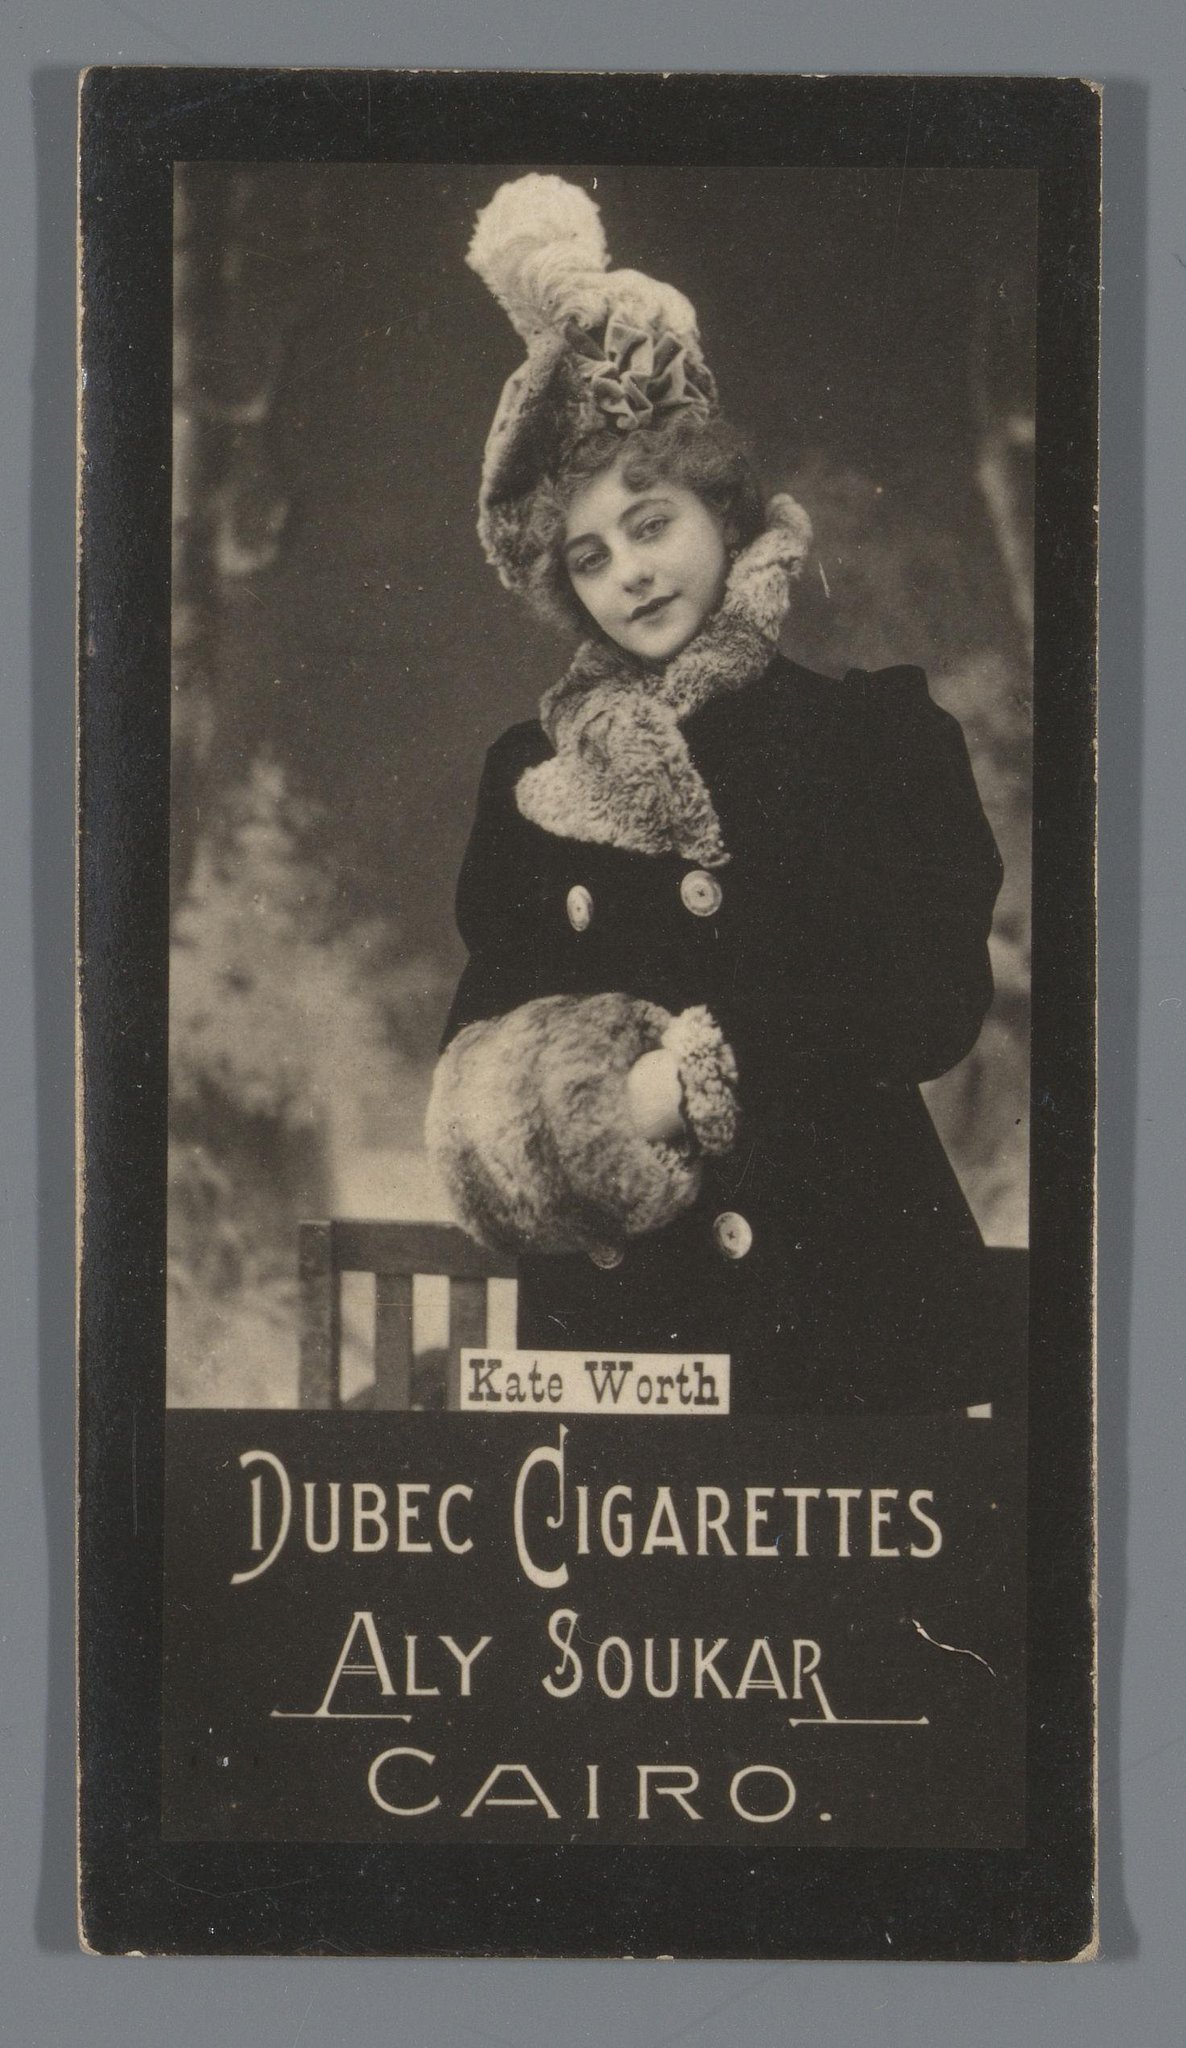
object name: photograph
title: Kate Worth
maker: Anonymous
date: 1895-1910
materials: photographic support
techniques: gelatin silver print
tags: historical persons - bb - woman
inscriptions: inscription: ‘DUBEC CIGARETTES/ ALY SOUKAR/ CAIRO.’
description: Dergelijke foto's stonden bekend als 'zwartjes'. Men verkreeg ze bij aanschaf van bepaalde merken thee, cacao, sigaretten, beschuit, etc. om te verzamelen. Er waren speciaal voor de 'zwartjes' verzamelalbums in omloop.